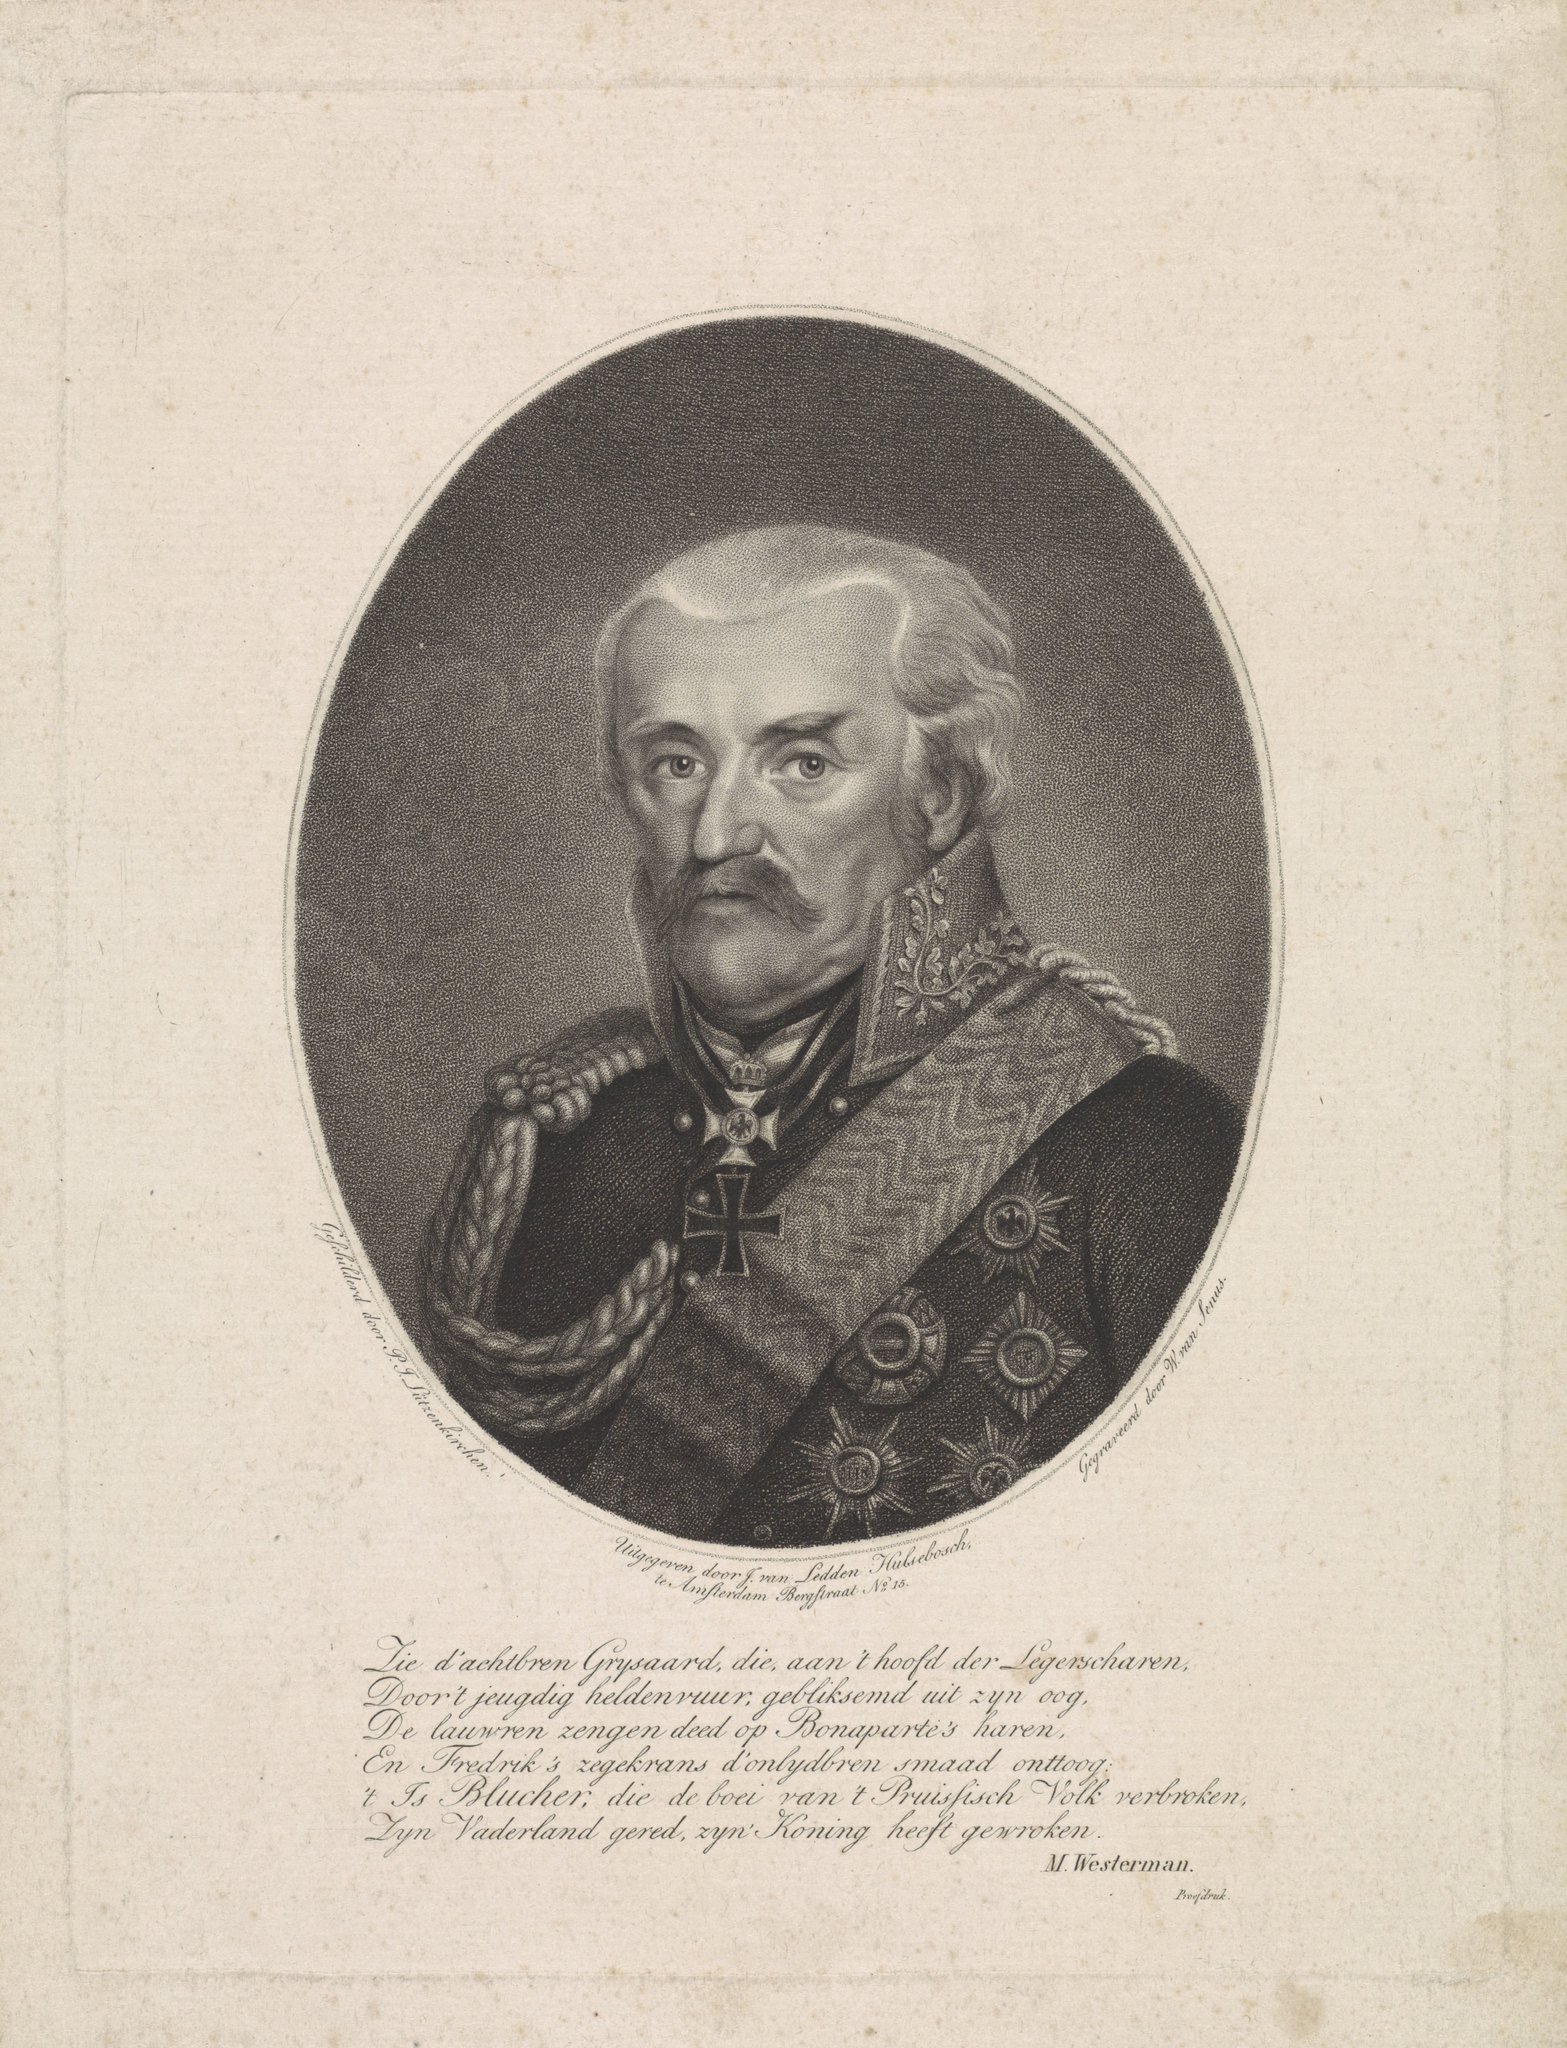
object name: print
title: Portret van Gebhard Leberecht von Blücher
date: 1815-1851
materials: paper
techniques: engraving, etching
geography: amsterdam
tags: rostock, generaal, gebhard leberecht von blücher von wahlstatt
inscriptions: collector's mark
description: Portret van de Pruisische generaal Gebhard Leberecht von Blücher. Hij leidde zijn leger tegen Napoleon Bonaparte in de Slag bij Waterloo in 1815.